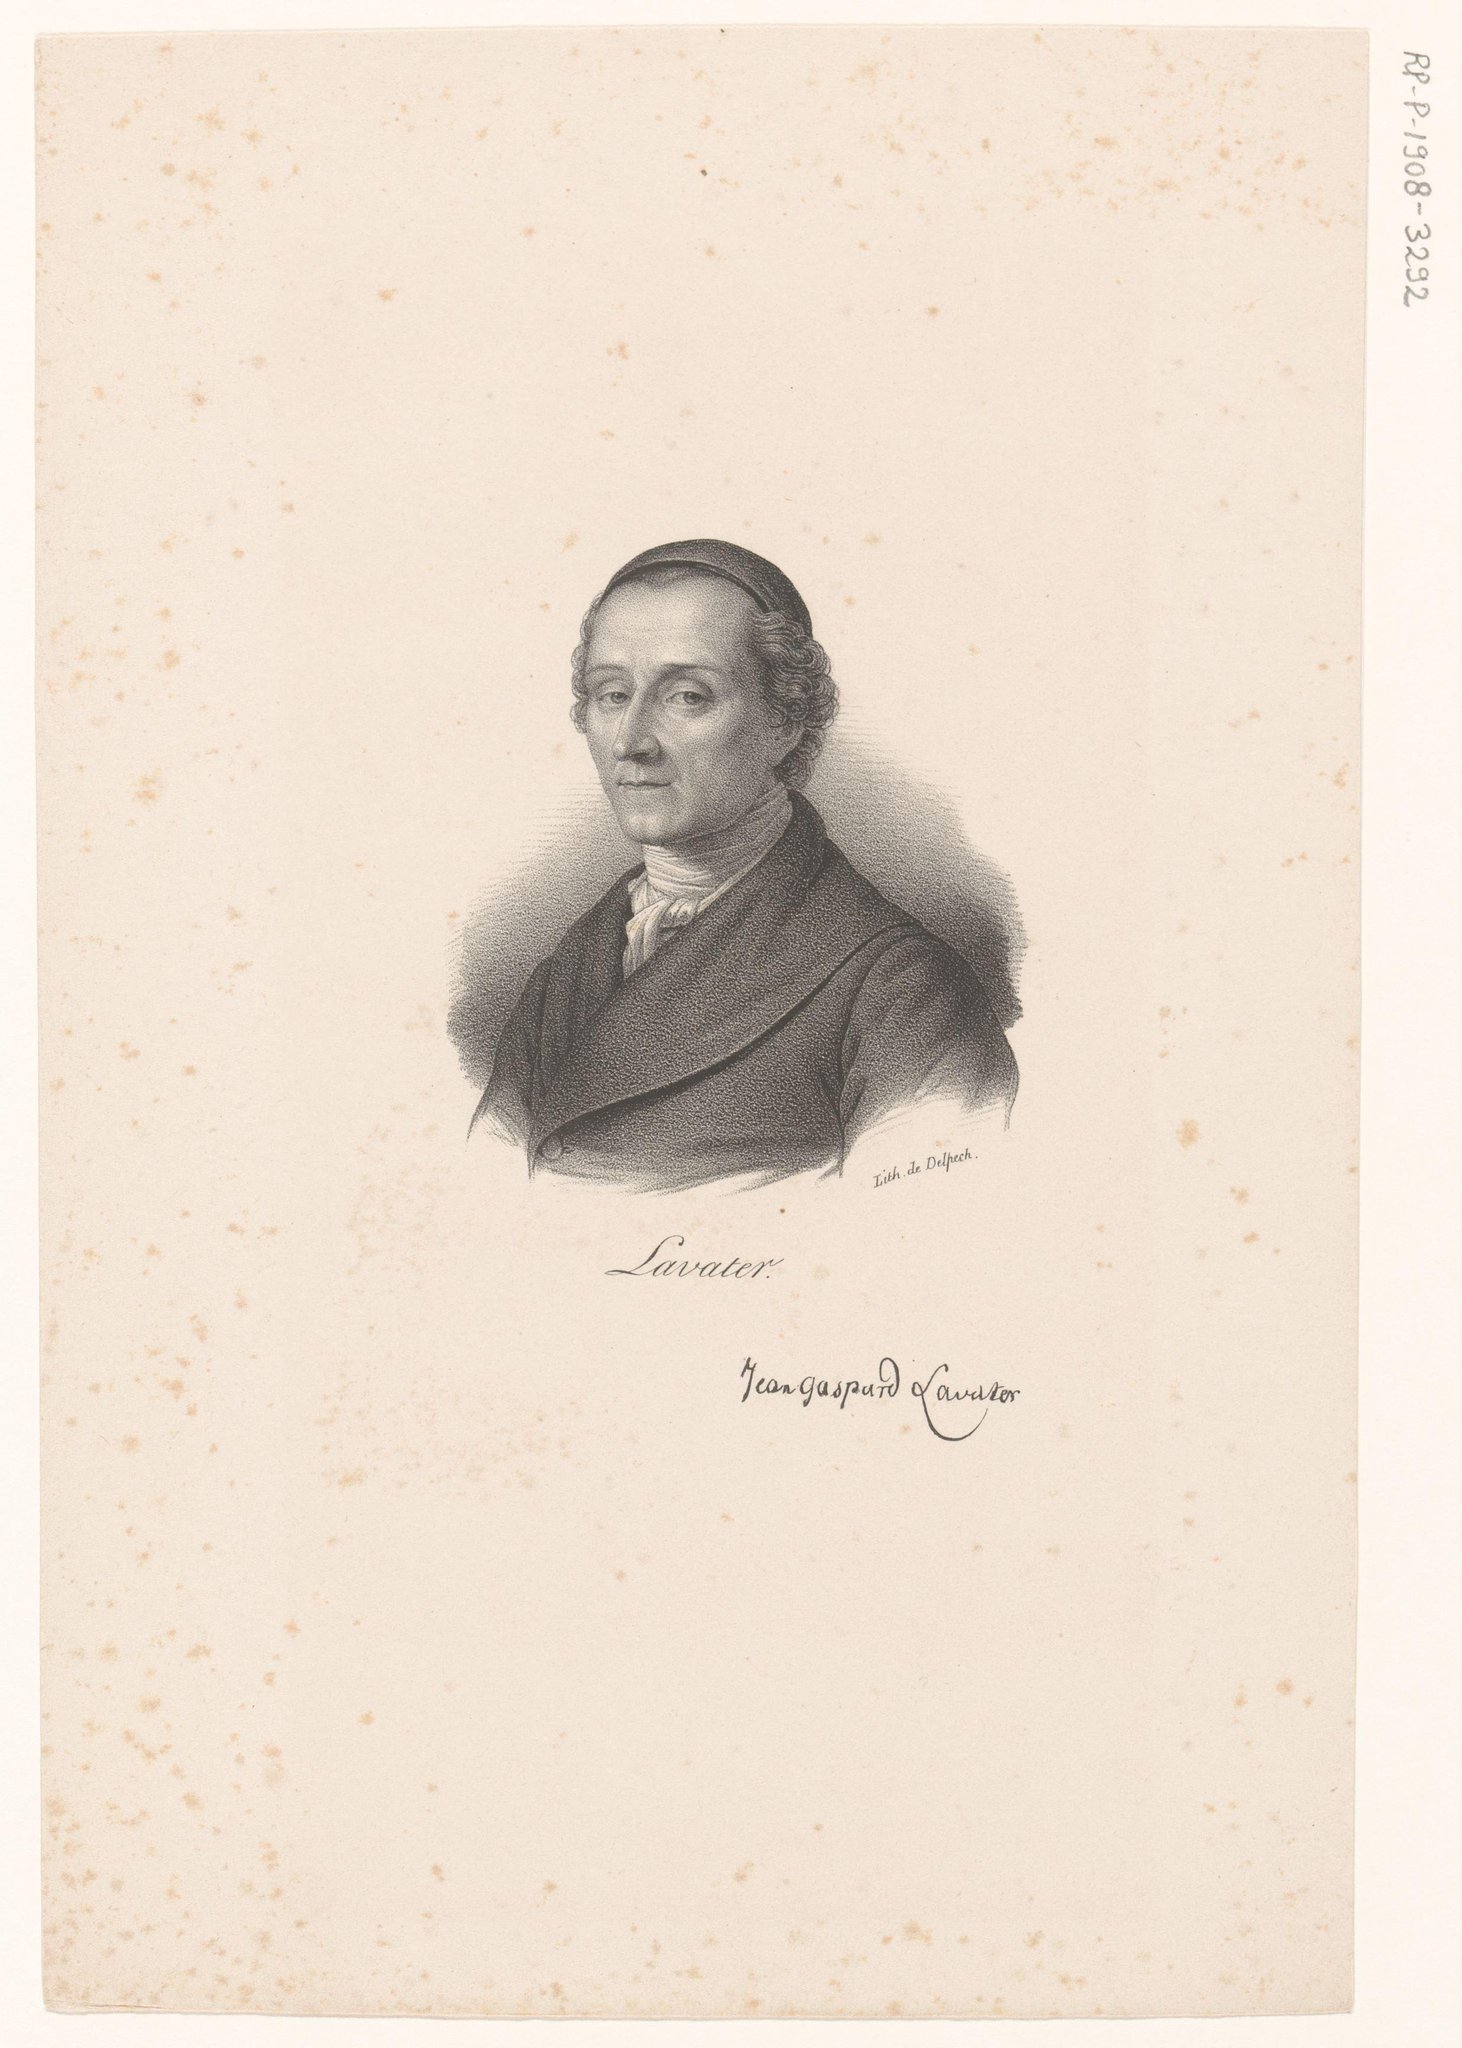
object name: print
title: Lavater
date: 1834-1842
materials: paper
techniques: lithograph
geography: paris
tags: johann caspar lavater, historical persons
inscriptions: collector's mark: Lugt 2228a